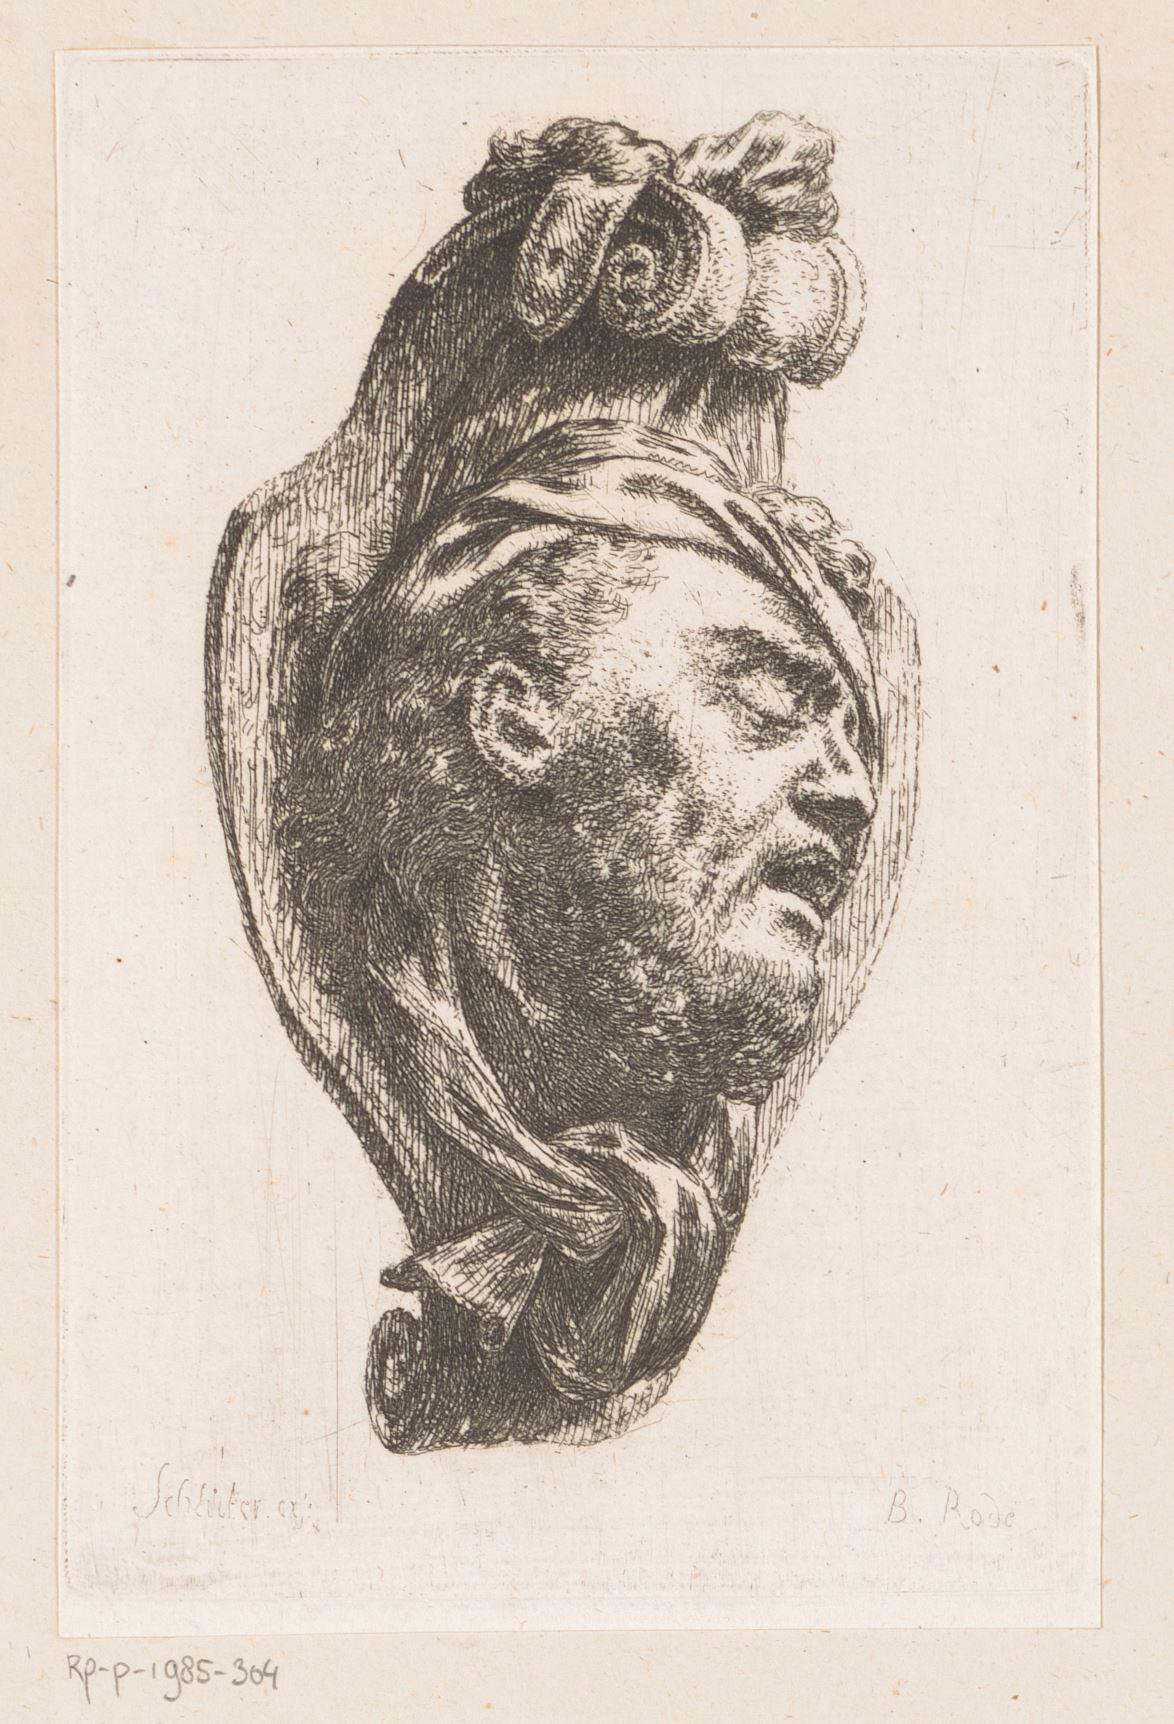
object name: print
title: Mascarons en helmen van het Zeughaus te Berlijn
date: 1759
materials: paper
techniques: etching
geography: berlin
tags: mask, mascaron ~ ornament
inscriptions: collector's mark: Lugt 2760, collector's mark: Lugt 2228